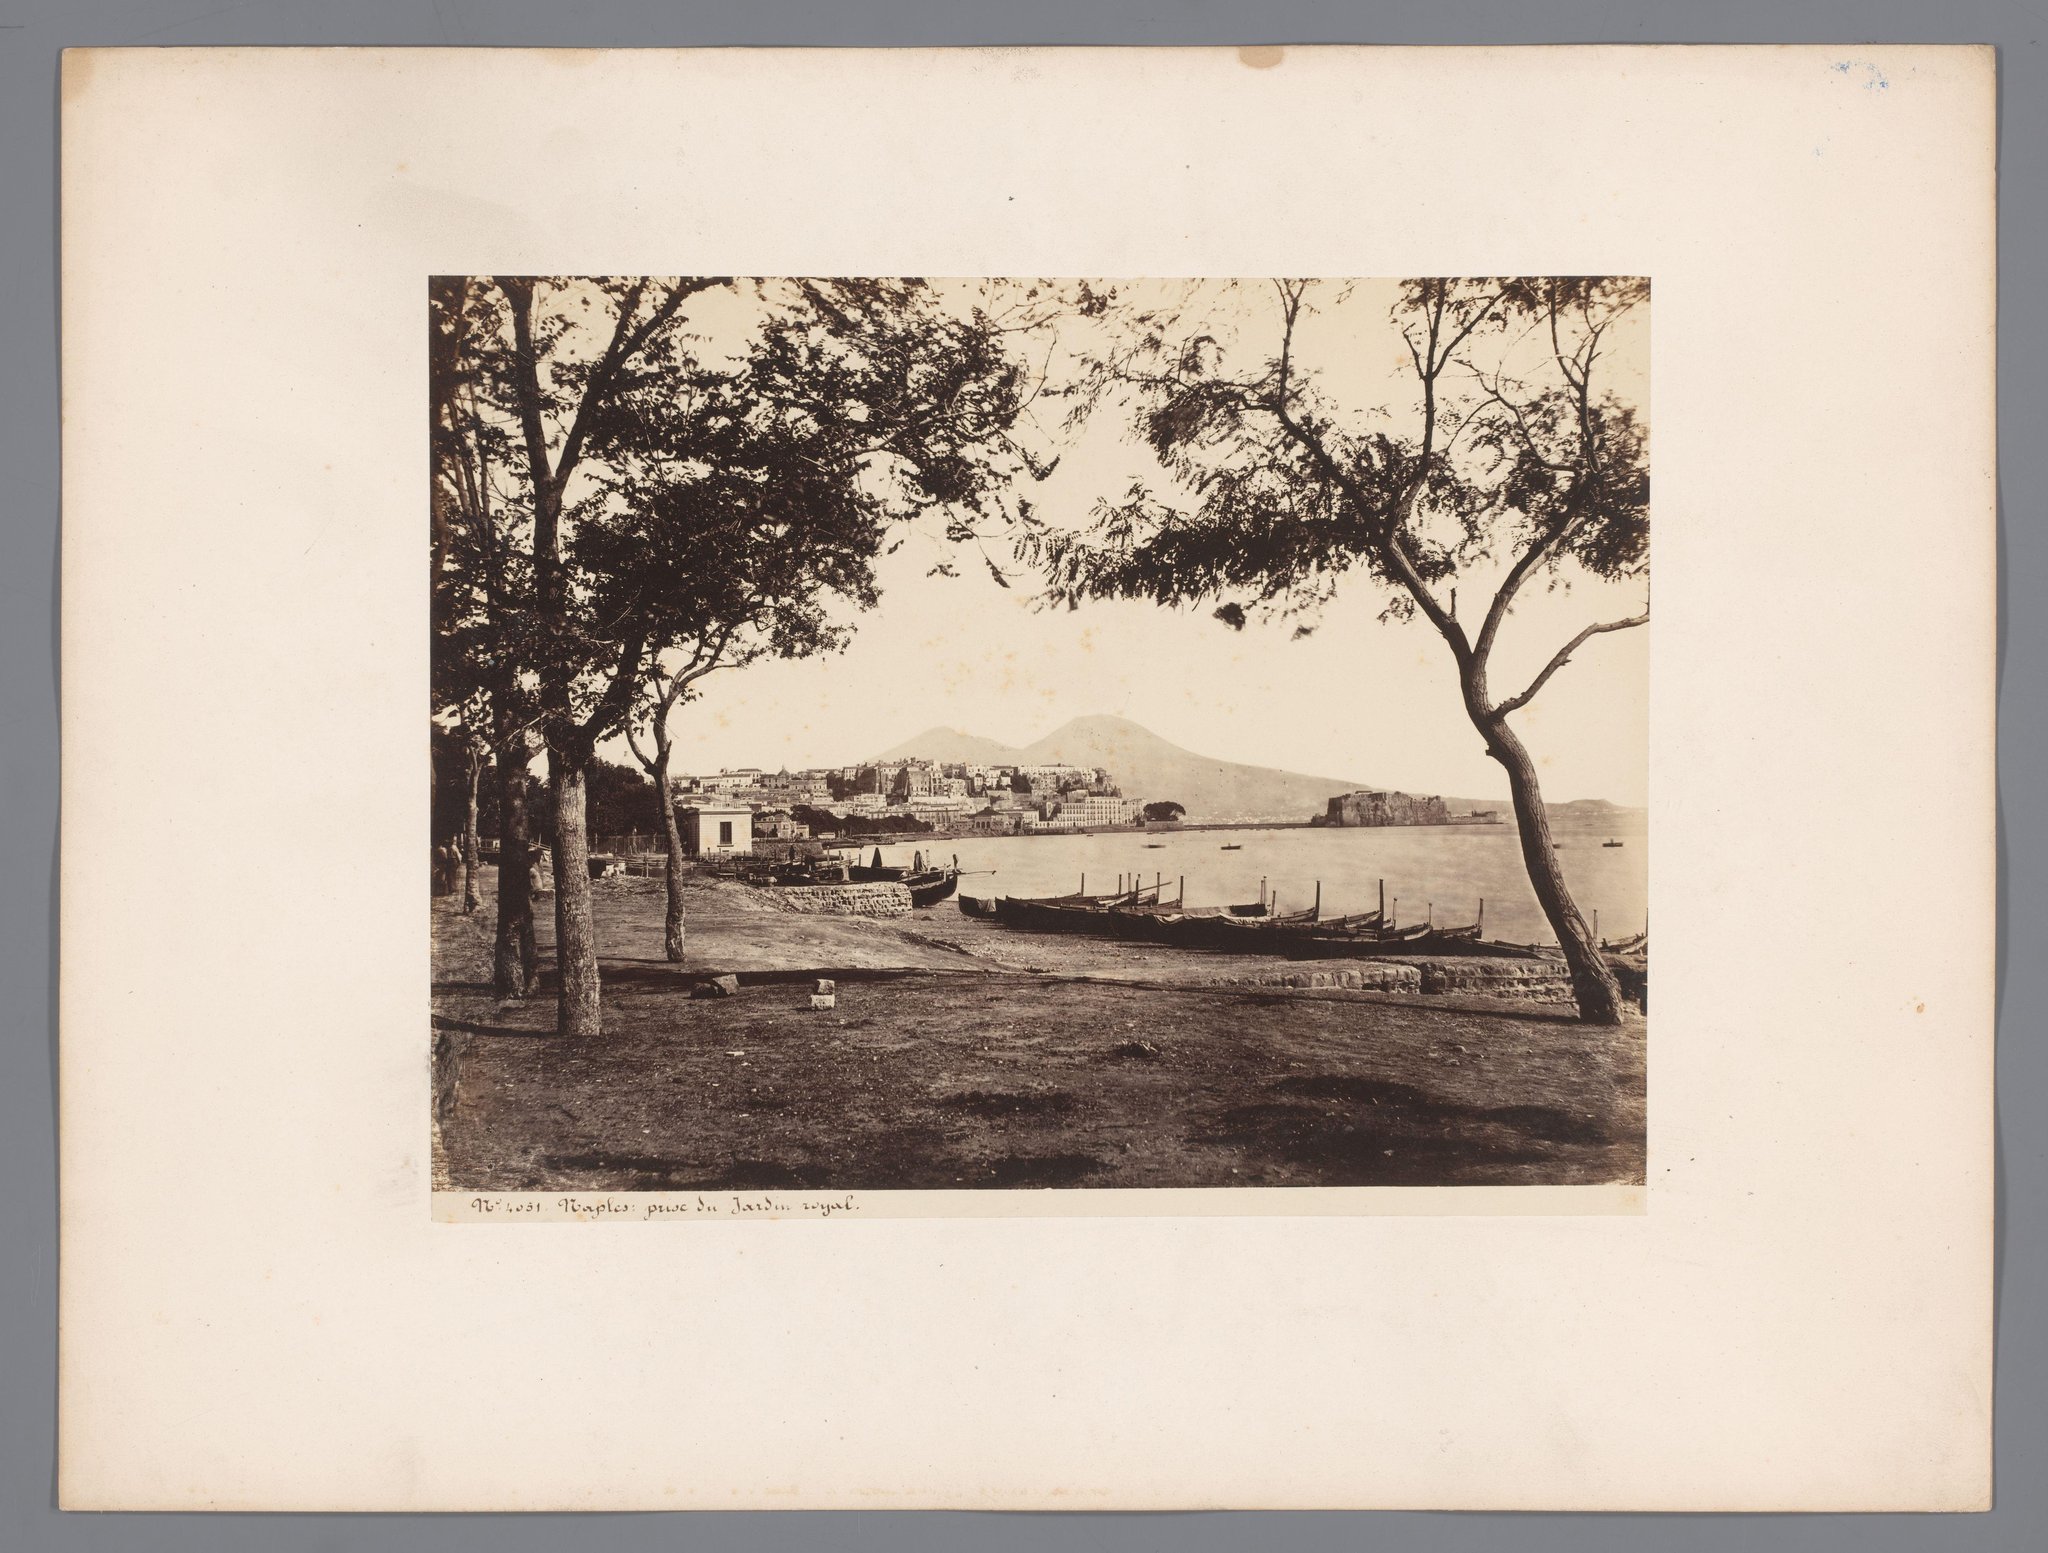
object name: photograph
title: Naples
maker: giorgio sommer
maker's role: fotograaf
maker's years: 1834-1914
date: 1857-1914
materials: cardboard, paper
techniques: albumen print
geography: naples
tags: gulf, bay, landscape with tower or castle, volcano, mount vesuvius, naples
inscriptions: number: ‘12’, number: ‘No. 4051’, number: ‘10-’